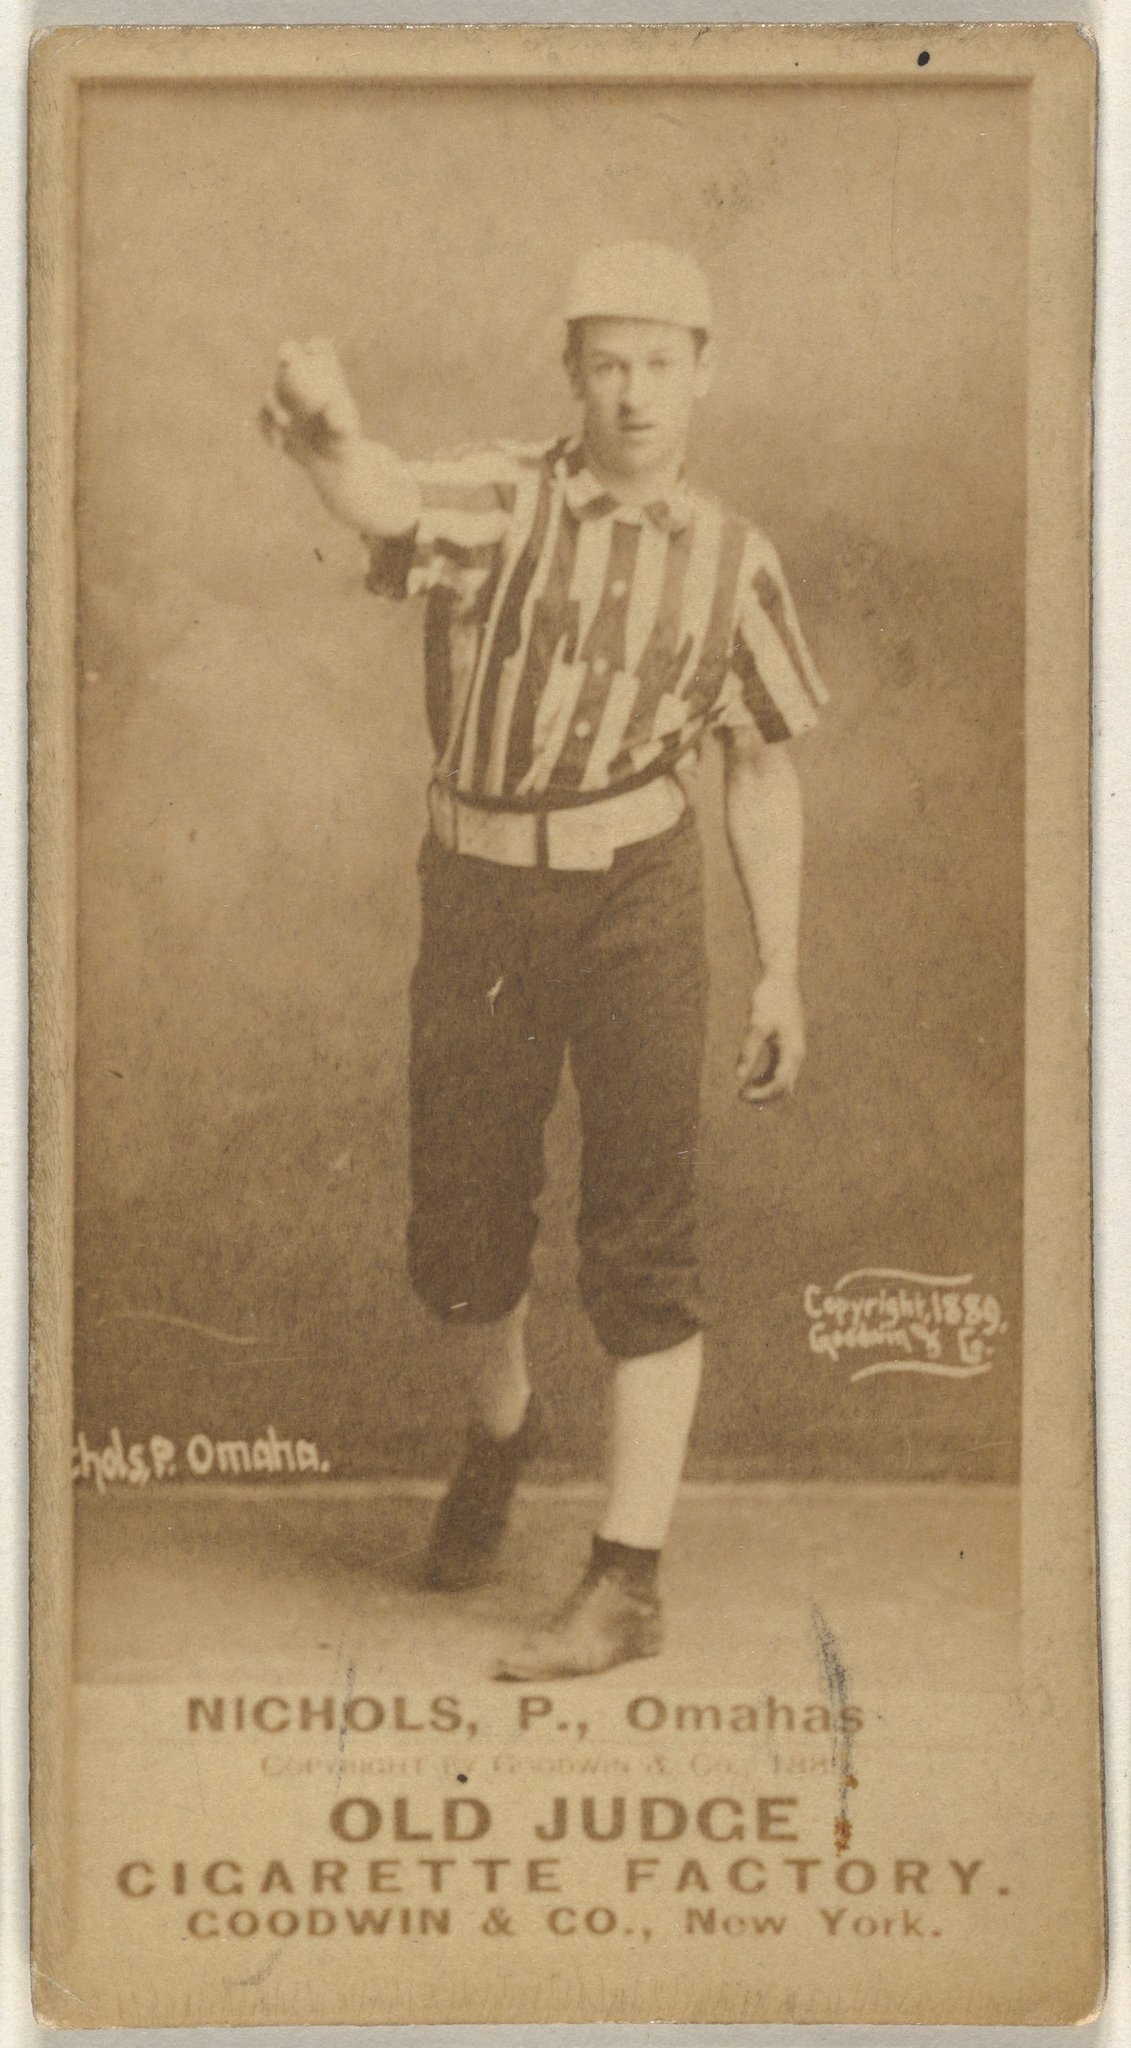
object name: baseball card, photograph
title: Charles Augustus "Kid" Nichols, Pitcher, Omaha Omahogs/ Lambs, from the Old Judge series (N172) for Old Judge Cigarettes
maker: goodwin & company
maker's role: publisher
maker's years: 1850-1950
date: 1889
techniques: albumen silver print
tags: men,portraits,baseball,athletes